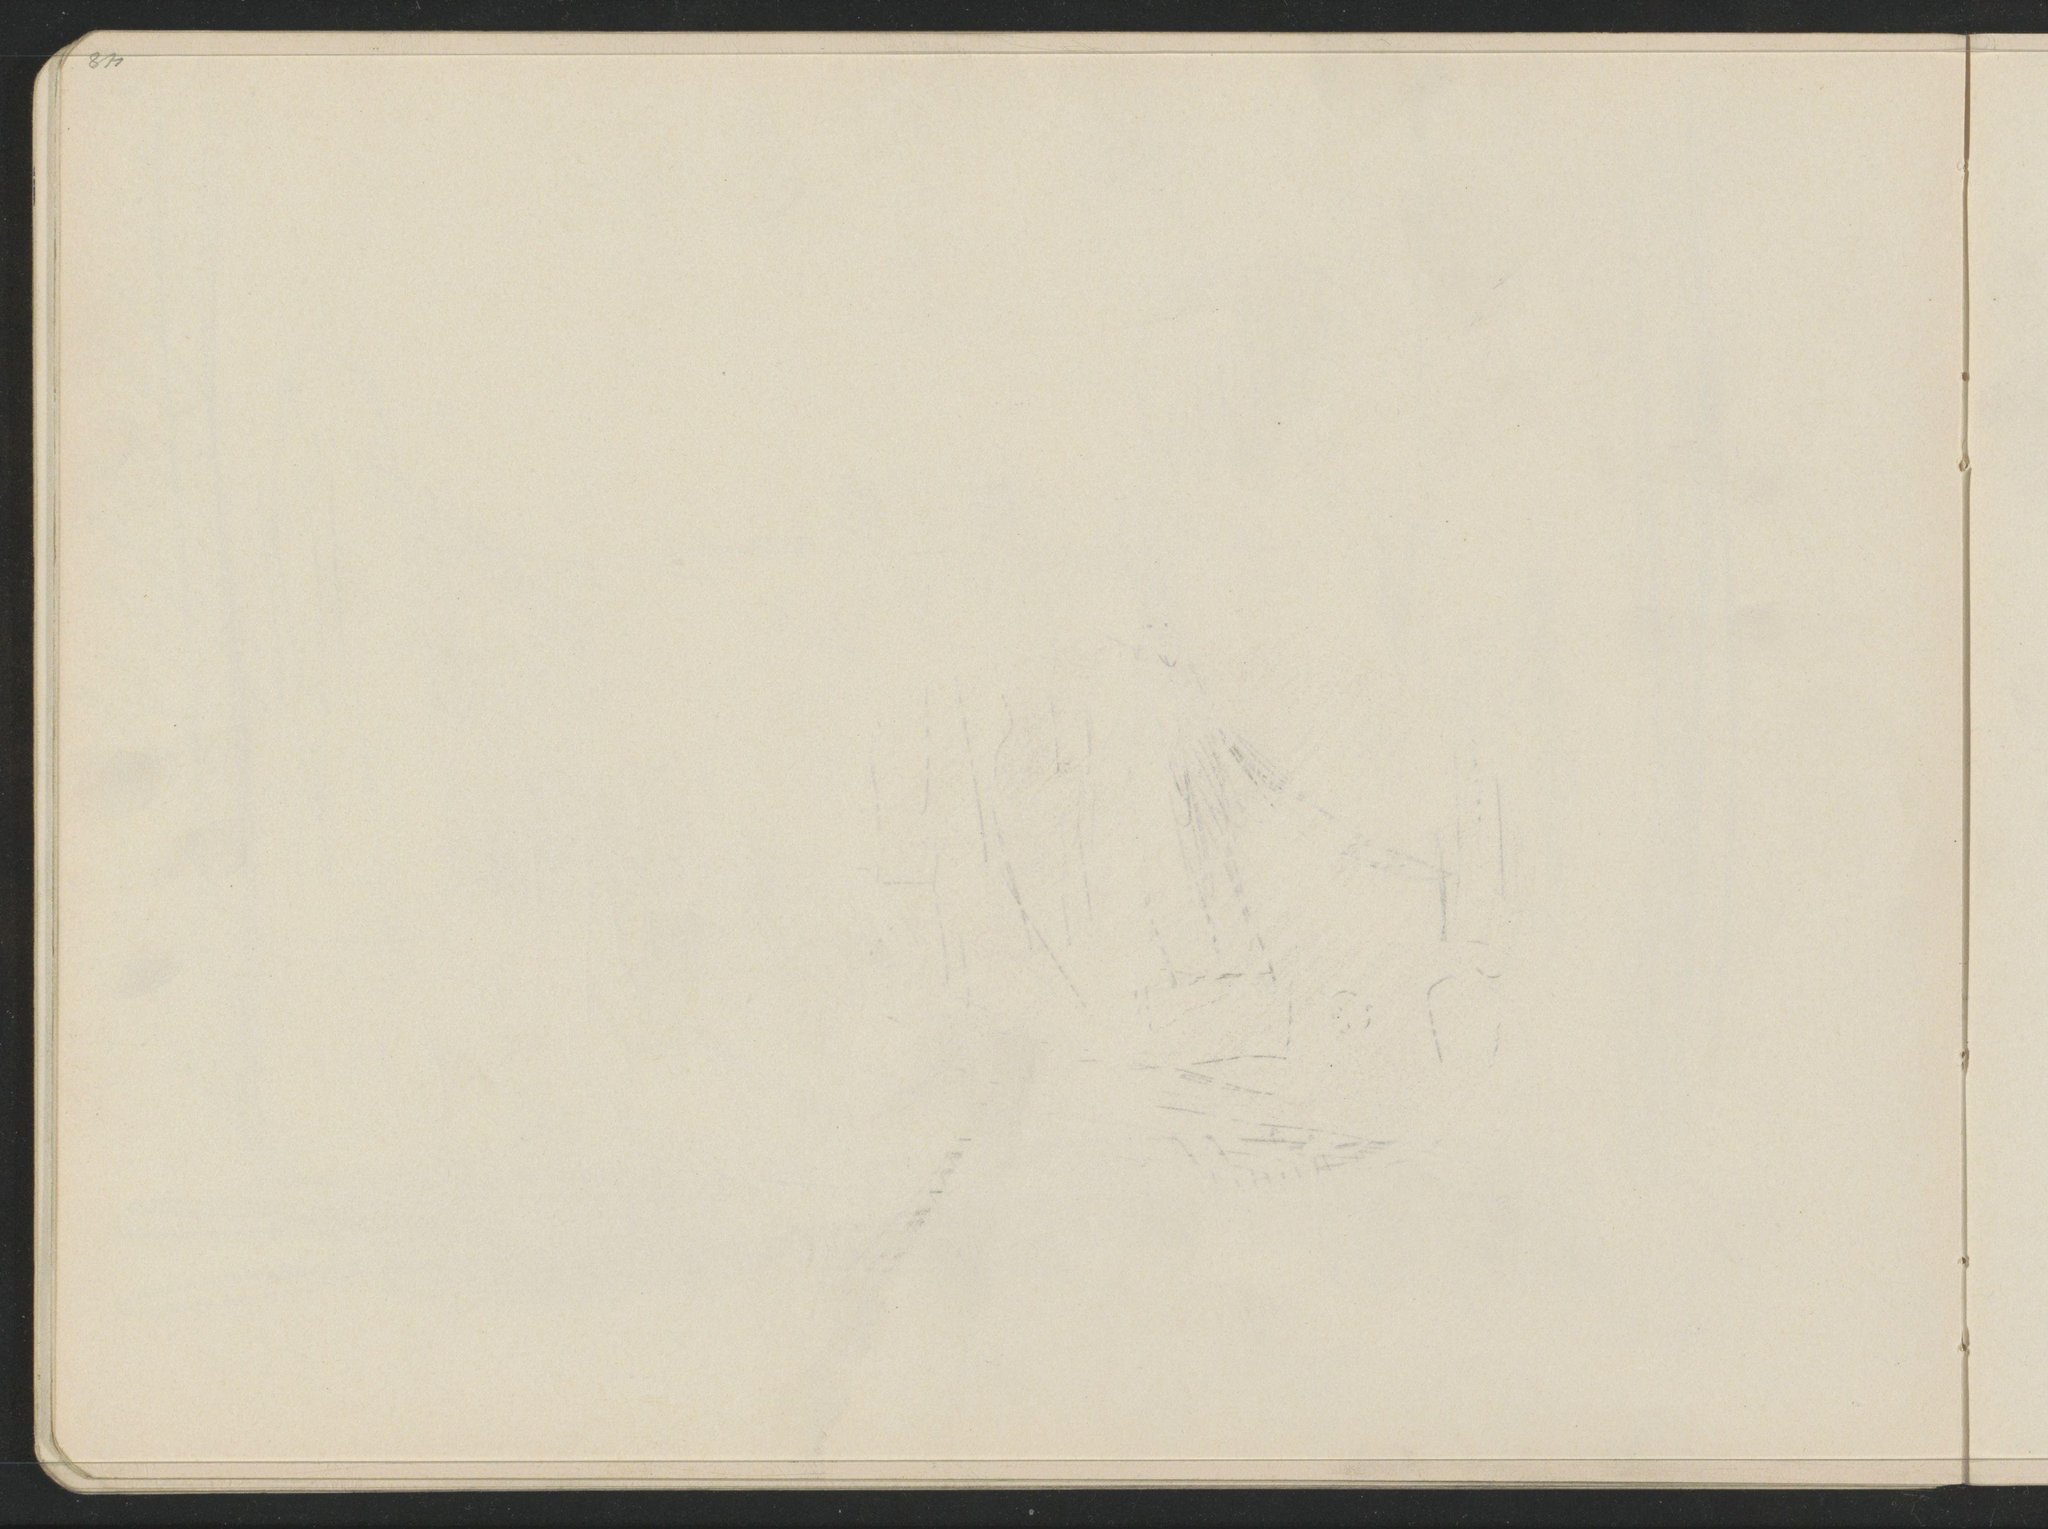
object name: sketchbook leaf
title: Abklatsch van de potloodtekening op blad 16 recto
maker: isaac israels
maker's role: draughtsman, painter, print maker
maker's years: 1865-1934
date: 1915-1934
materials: paper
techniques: printmaking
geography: the hague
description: Blad 15 verso uit schetsboek XVII met 31 bladen.